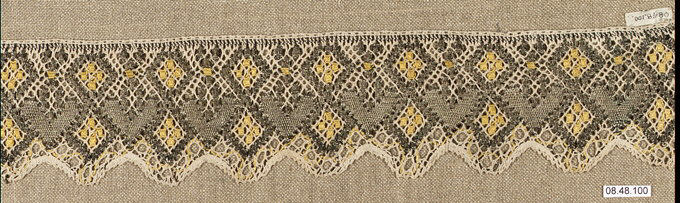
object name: edging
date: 1801-1900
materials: cotton, metal thread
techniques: lace